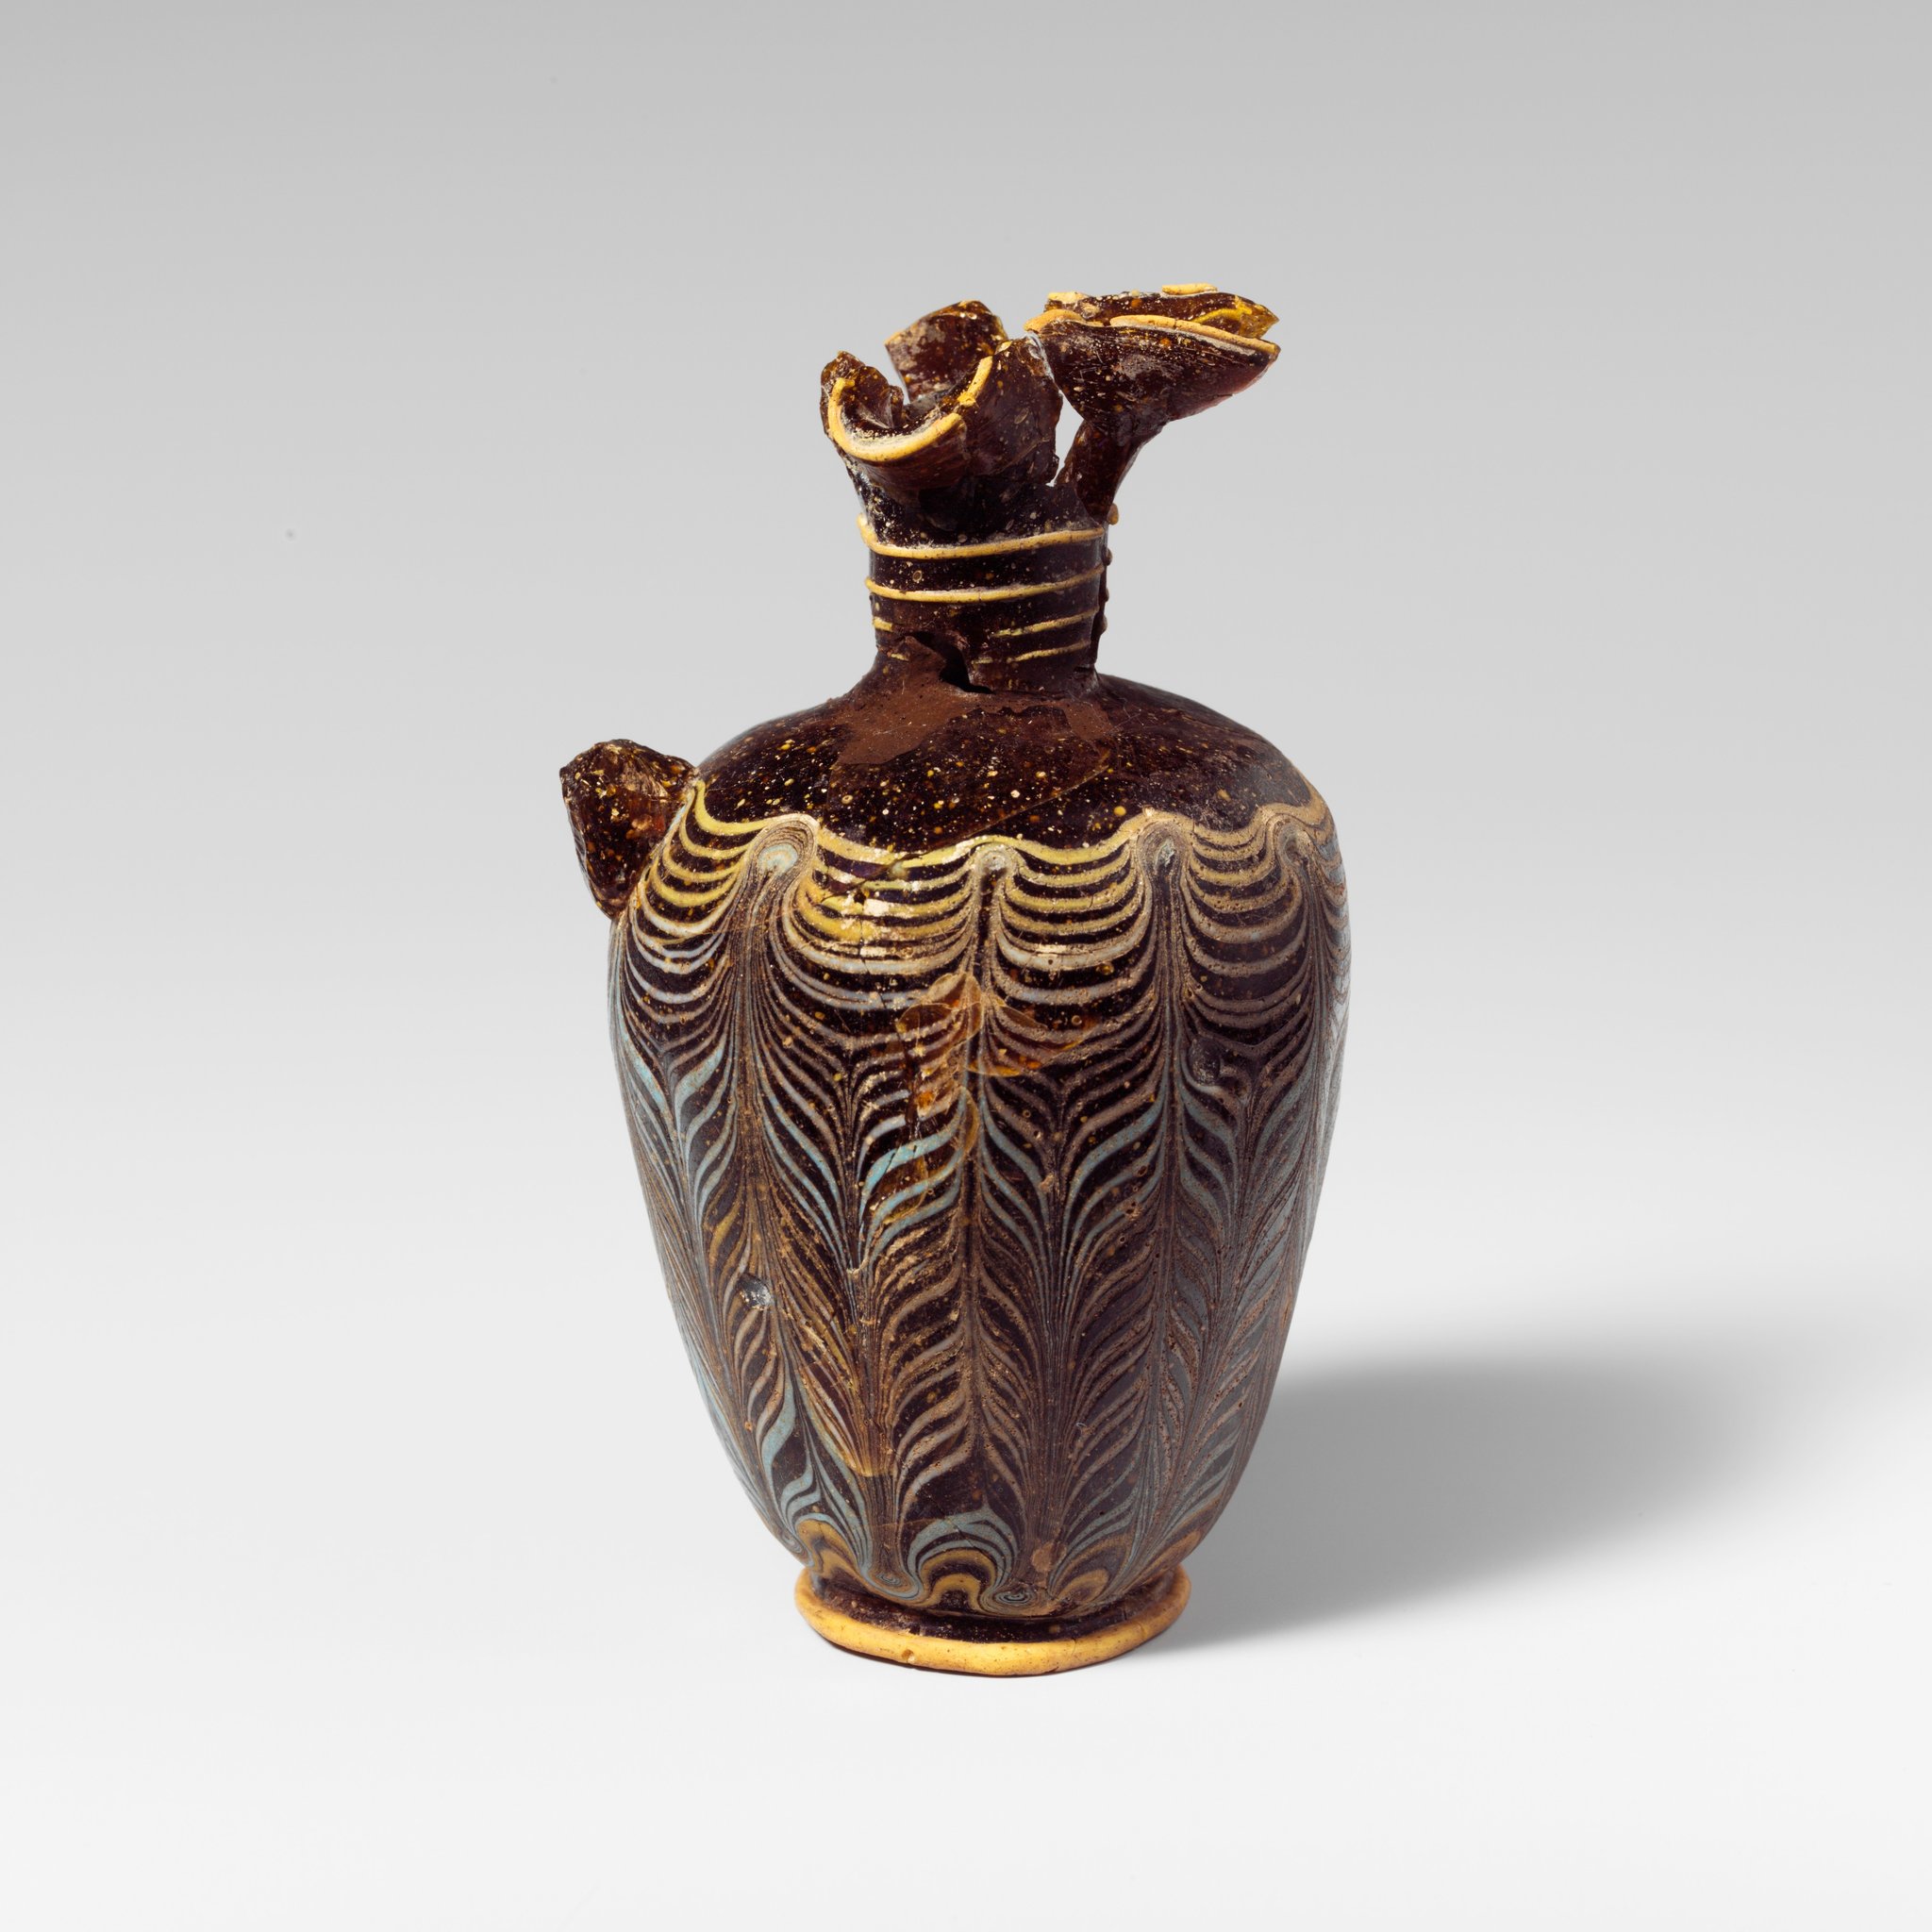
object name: oinochoe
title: Glass oinochoe (perfume jug)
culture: greek or eastern mediterranean or italian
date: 367-268 BCE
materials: glass